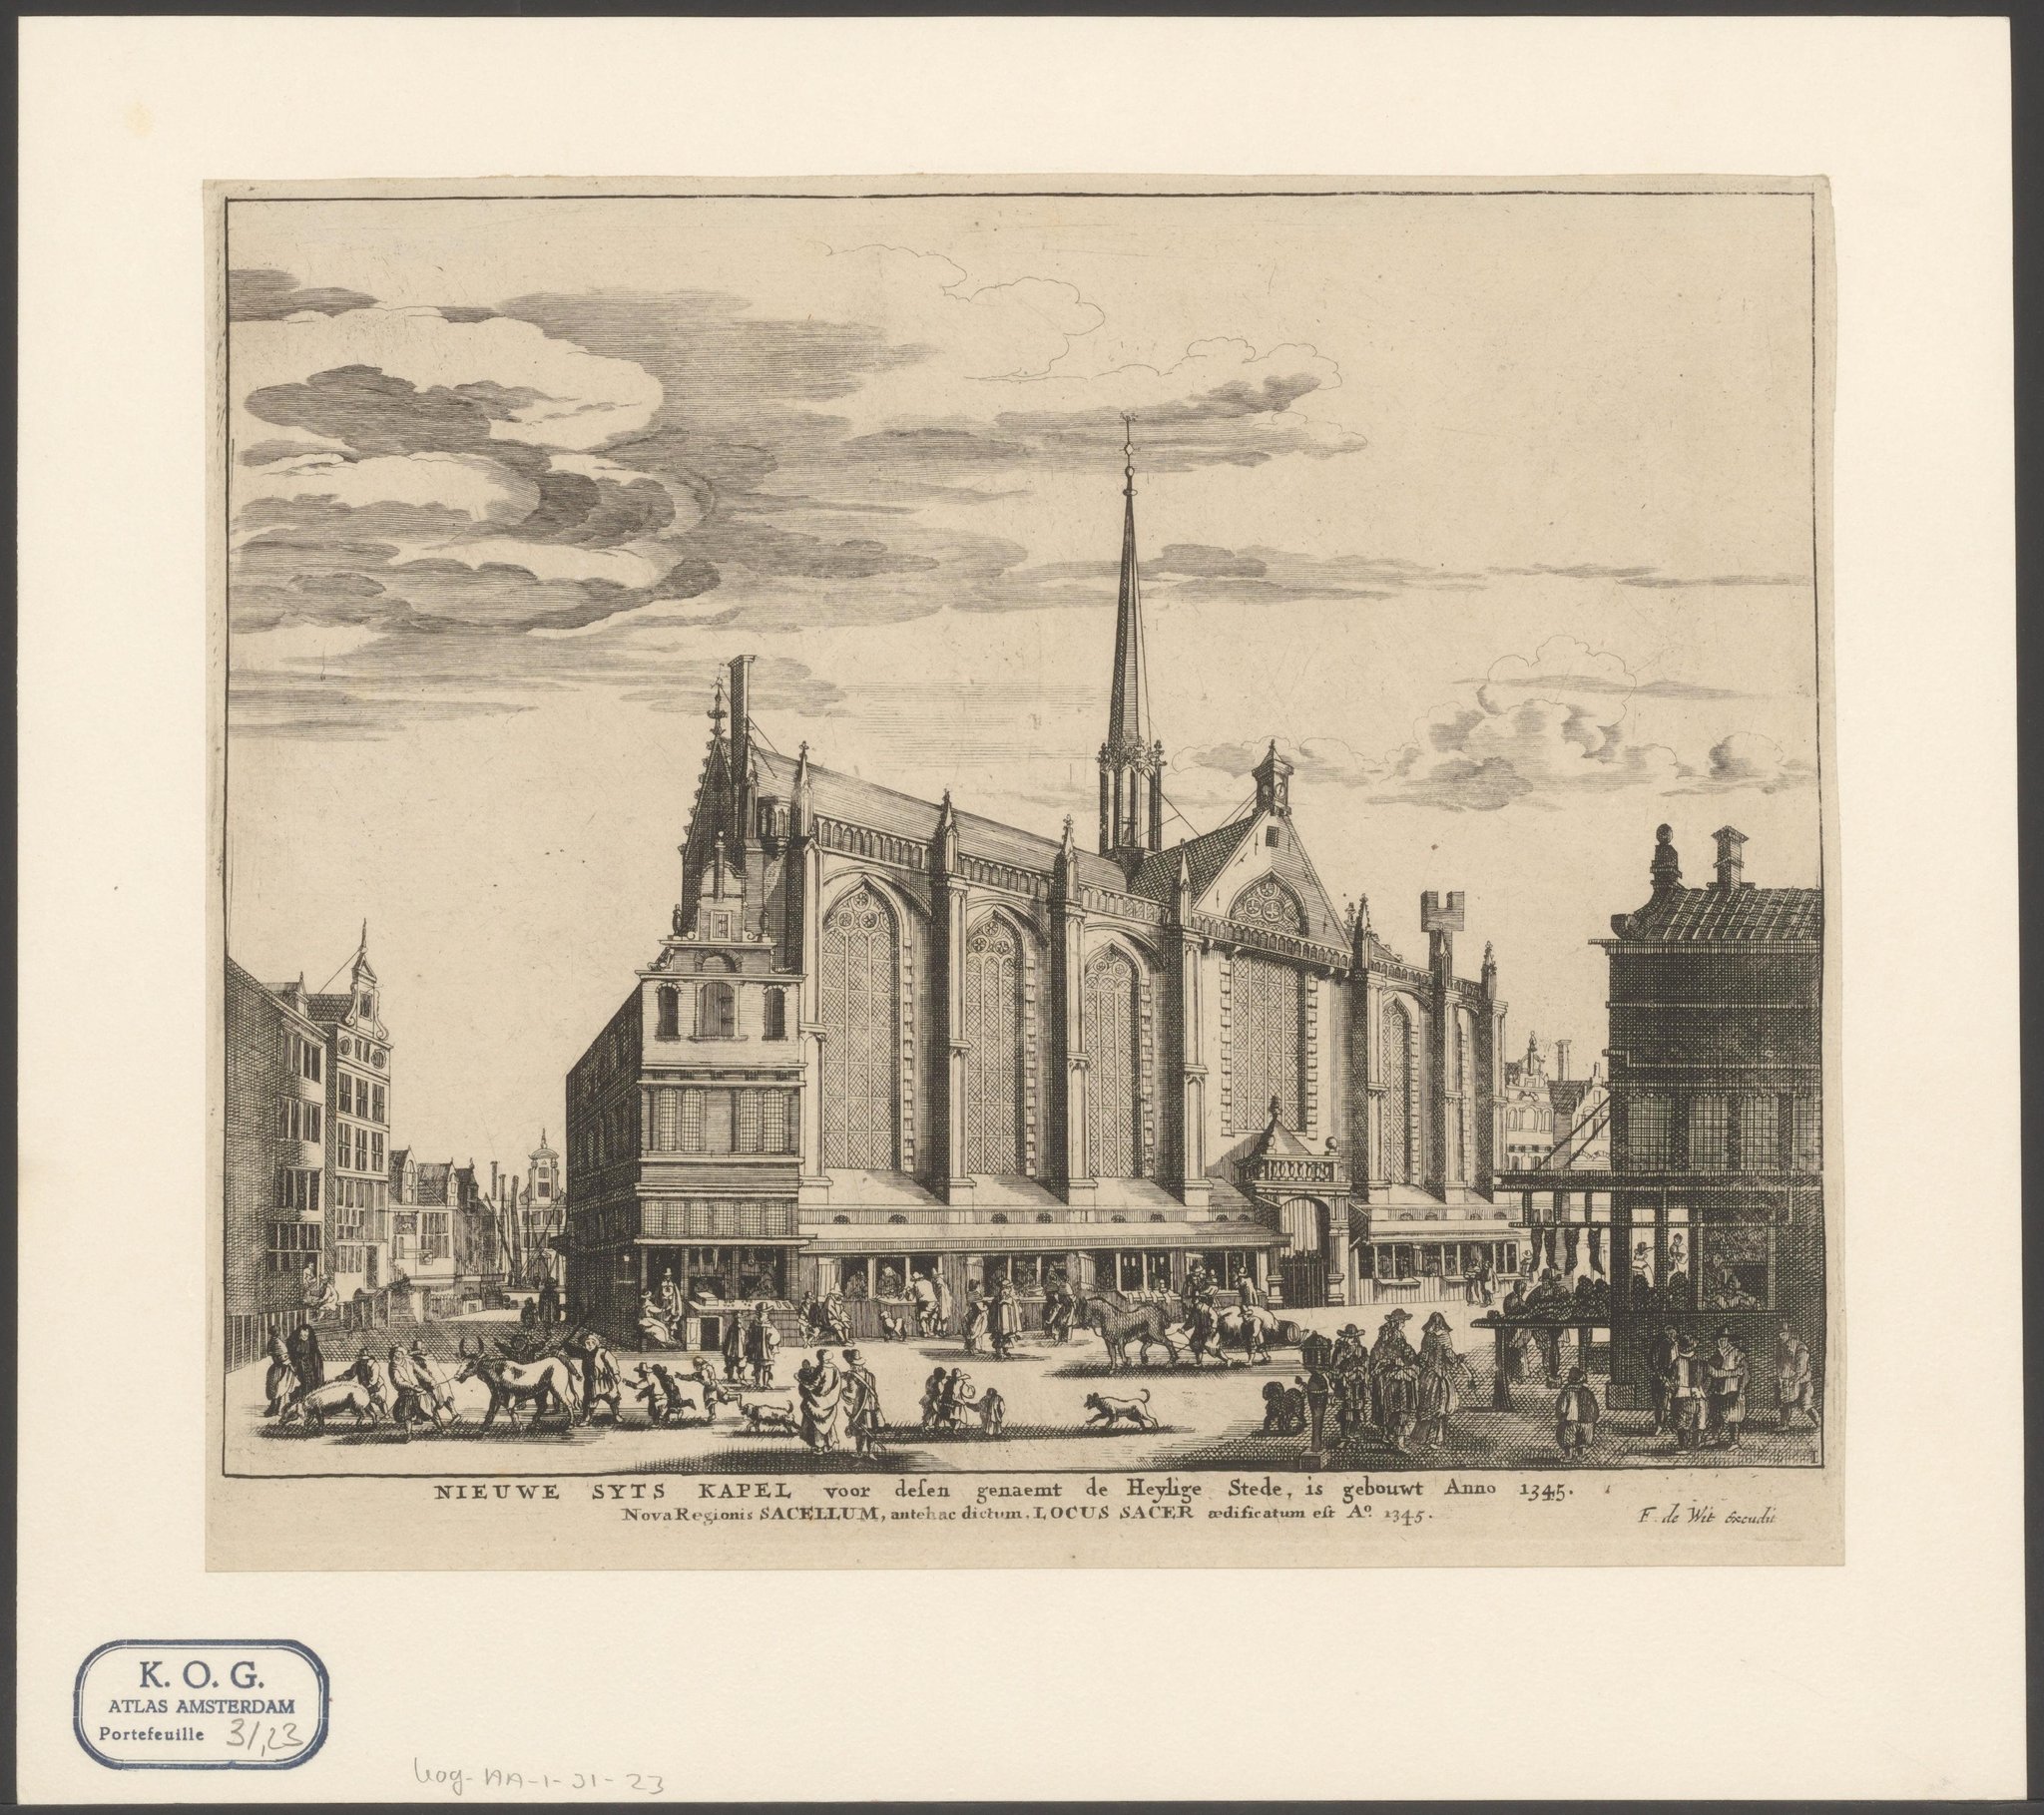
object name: print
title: Gezicht op de Nieuwezijds Kapel te Amsterdam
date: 1662-1706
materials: paper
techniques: engraving, etching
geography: northern netherlands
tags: church (exterior) - qq - small church, chapel, street (+ city(-scape) with figures, staffage)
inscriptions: collector's mark: Lugt 1641b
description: Rechtsonder genummerd: I. Onderwerpsrubriek binnen de Atlas Amsterdam: Kerkwezen: Hervormde Gemeente: Nieuwezijds Kapel.